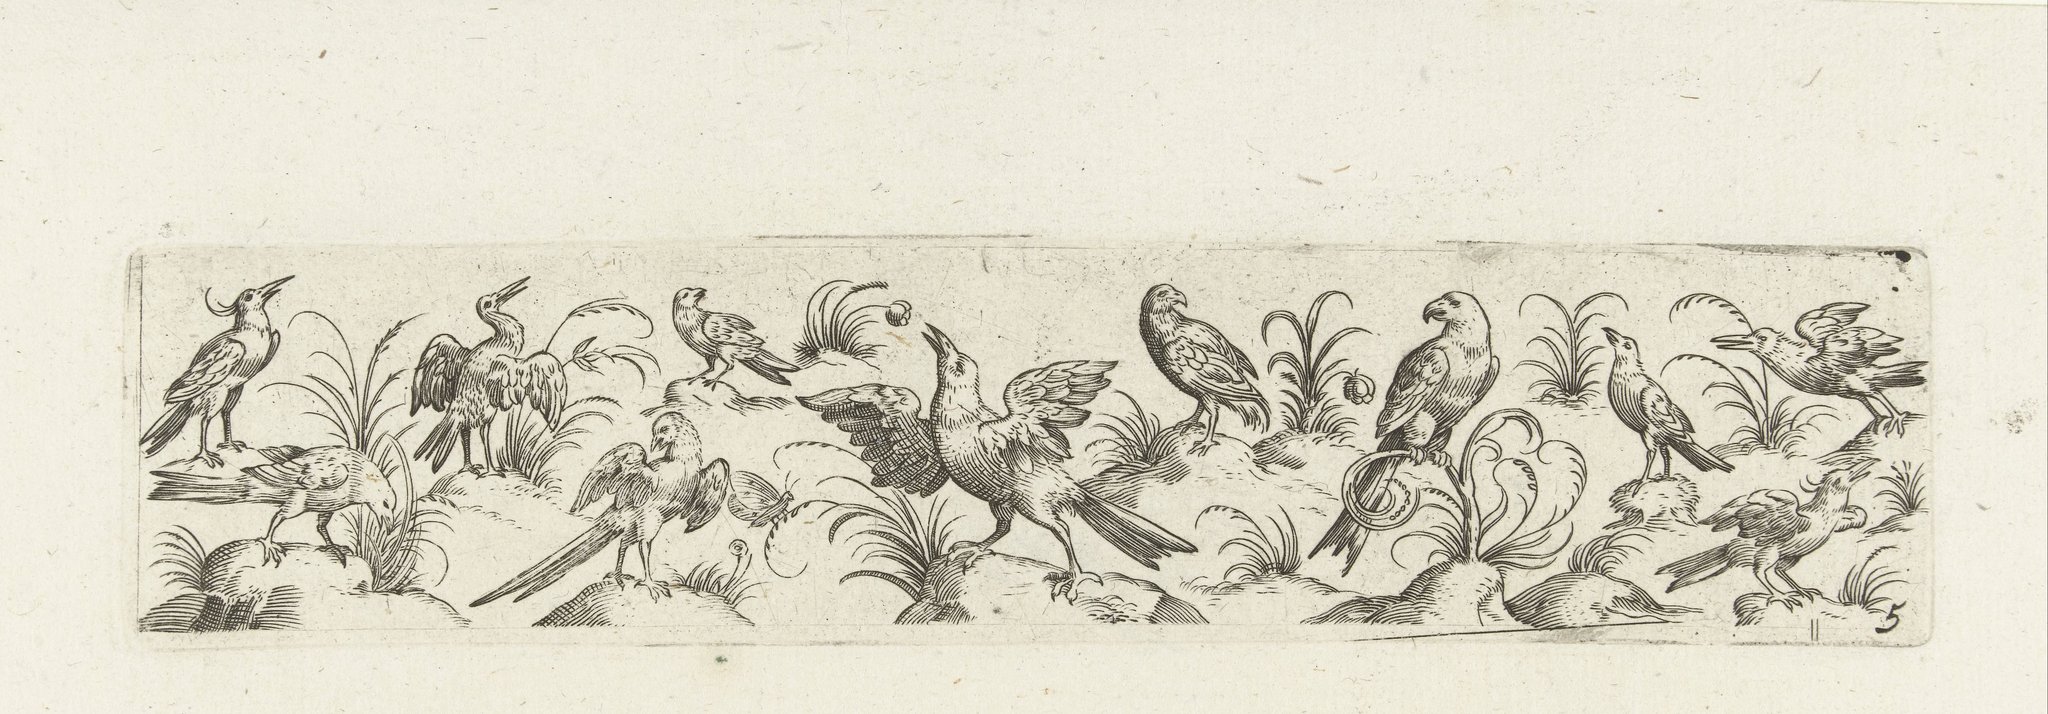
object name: print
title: Fries met elf vogels en een insect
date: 1607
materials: paper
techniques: engraving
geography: netherlands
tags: birds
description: De vogel in het midden heeft de vleugels gespreid en kijkt omhoog. Nummer 5 uit serie van 12 genummerde bladen.